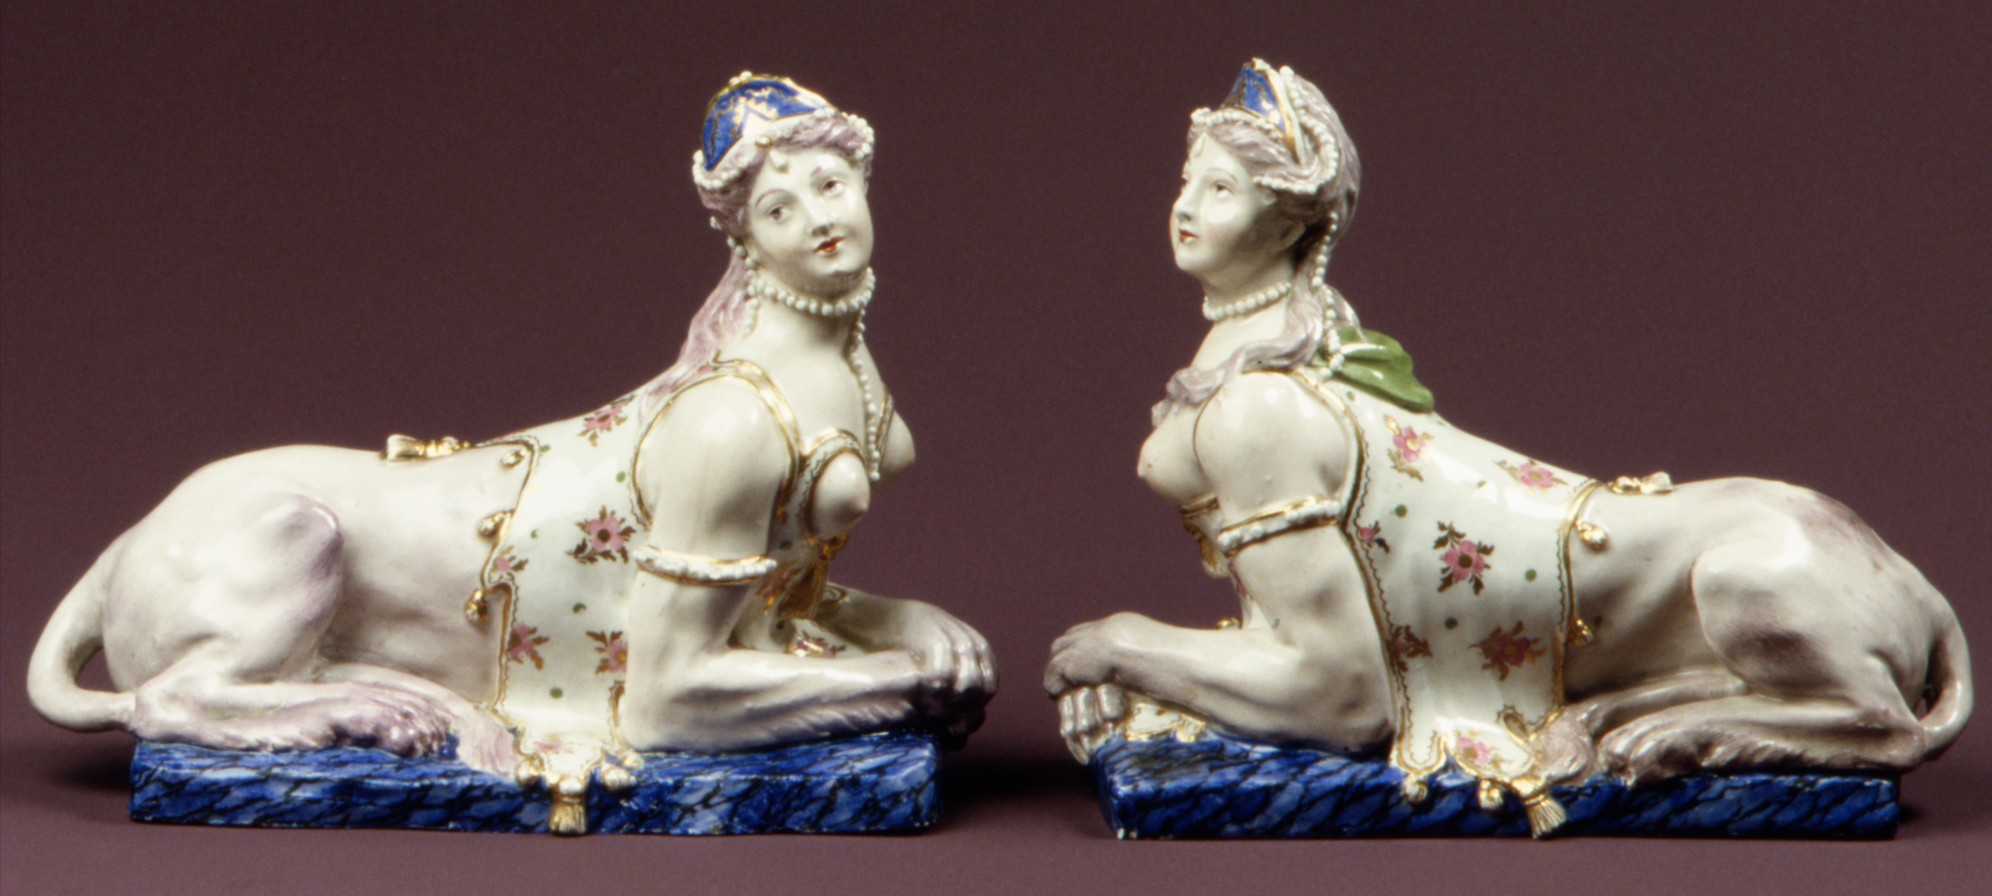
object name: figure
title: Pair of sphinxes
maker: bristol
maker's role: factory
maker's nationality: british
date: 1770-1773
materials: hard paste porcelain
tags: sphinx